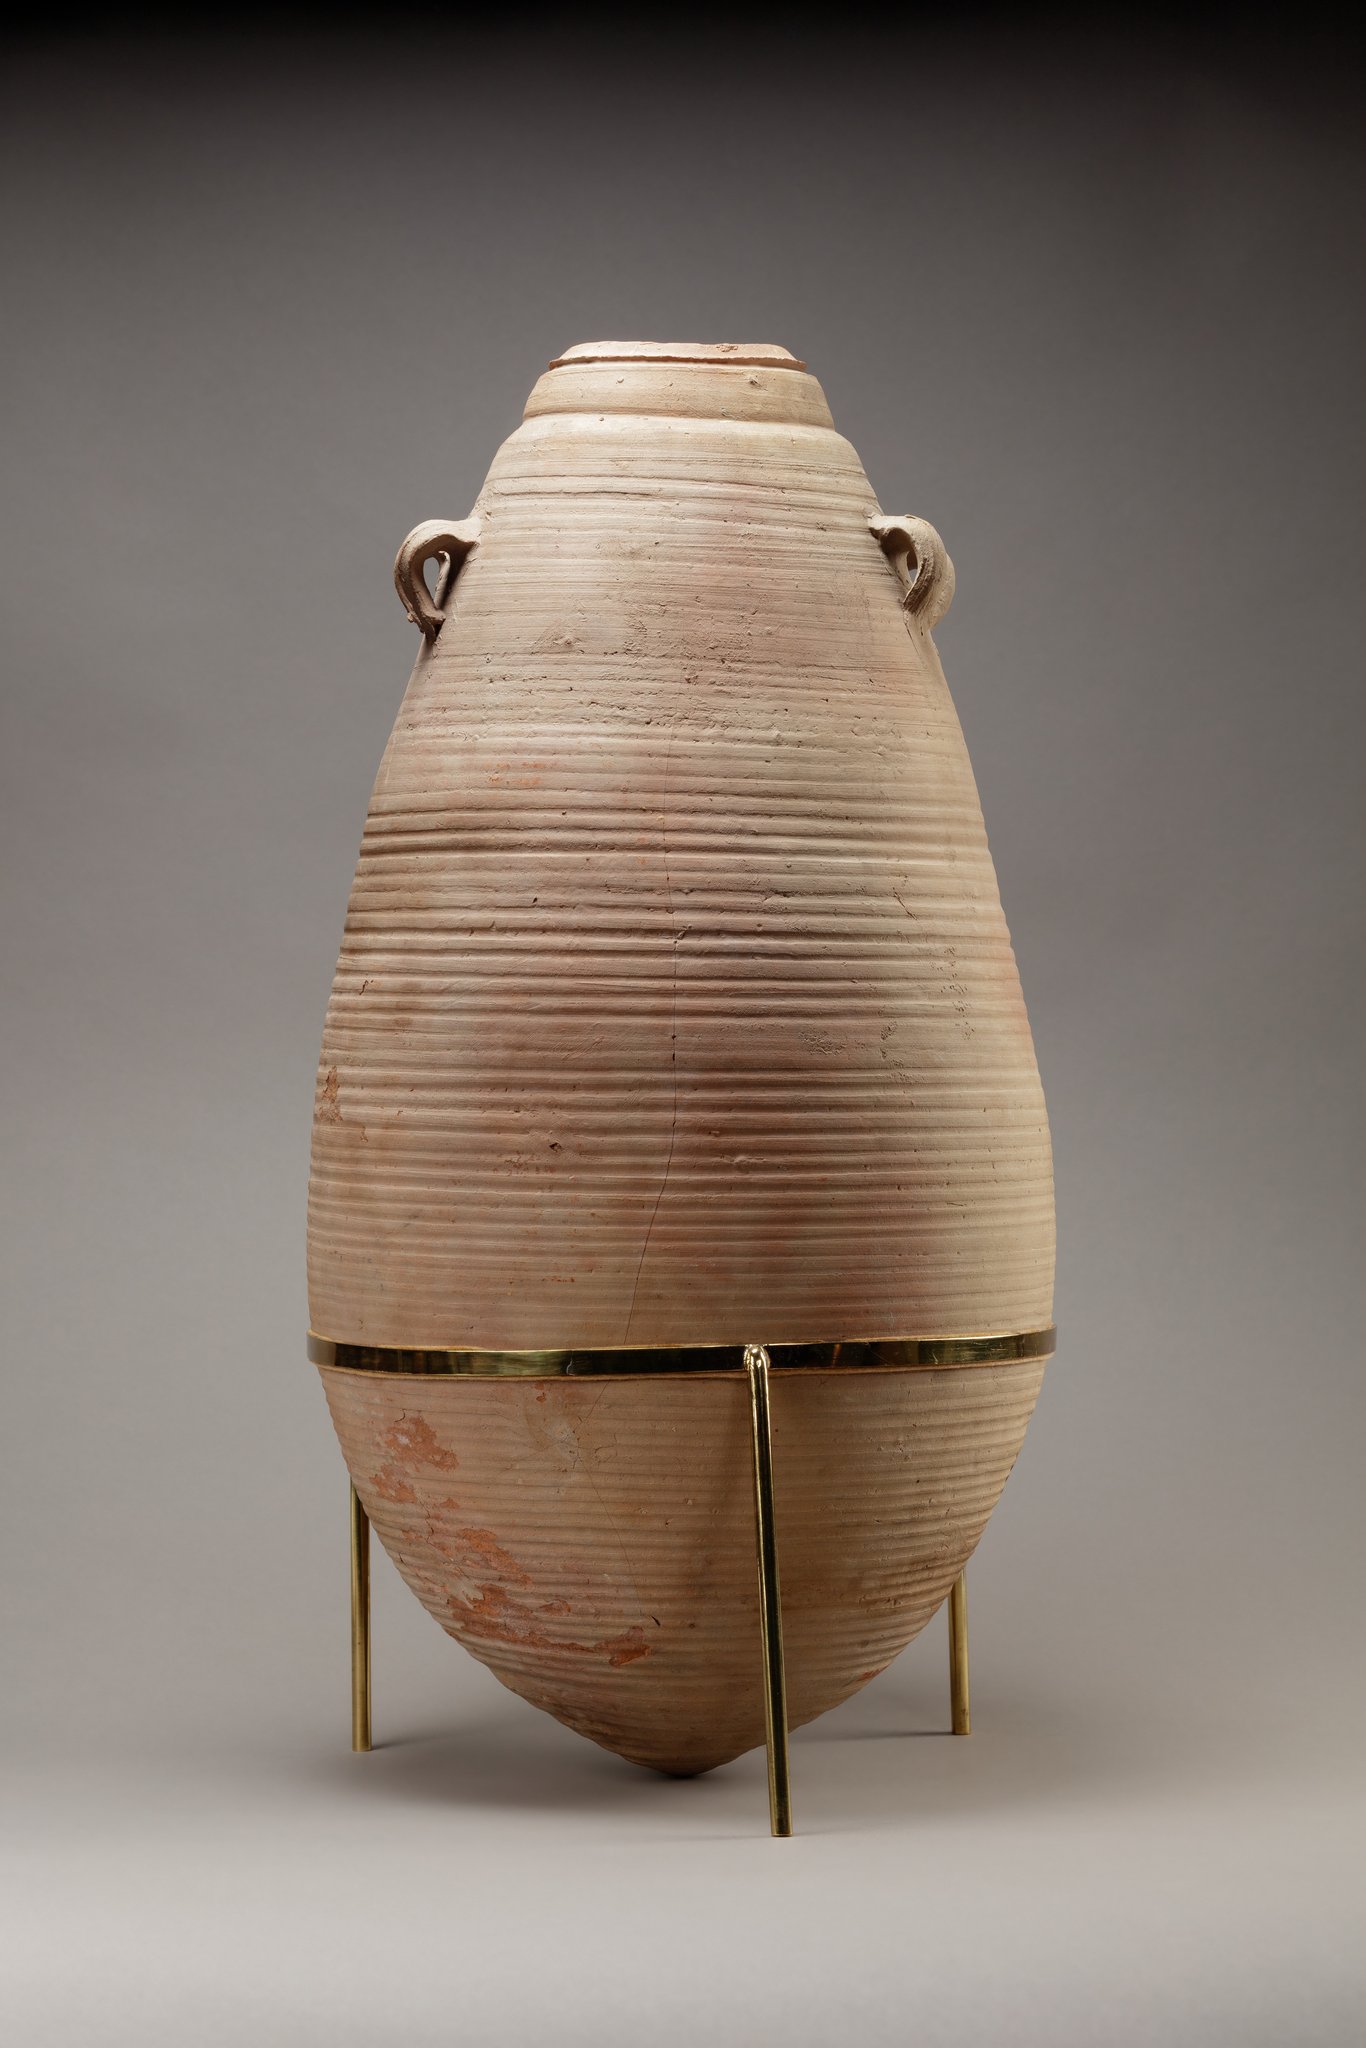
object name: vase, tall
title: Pot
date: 664-332 BCE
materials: pottery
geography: egypt